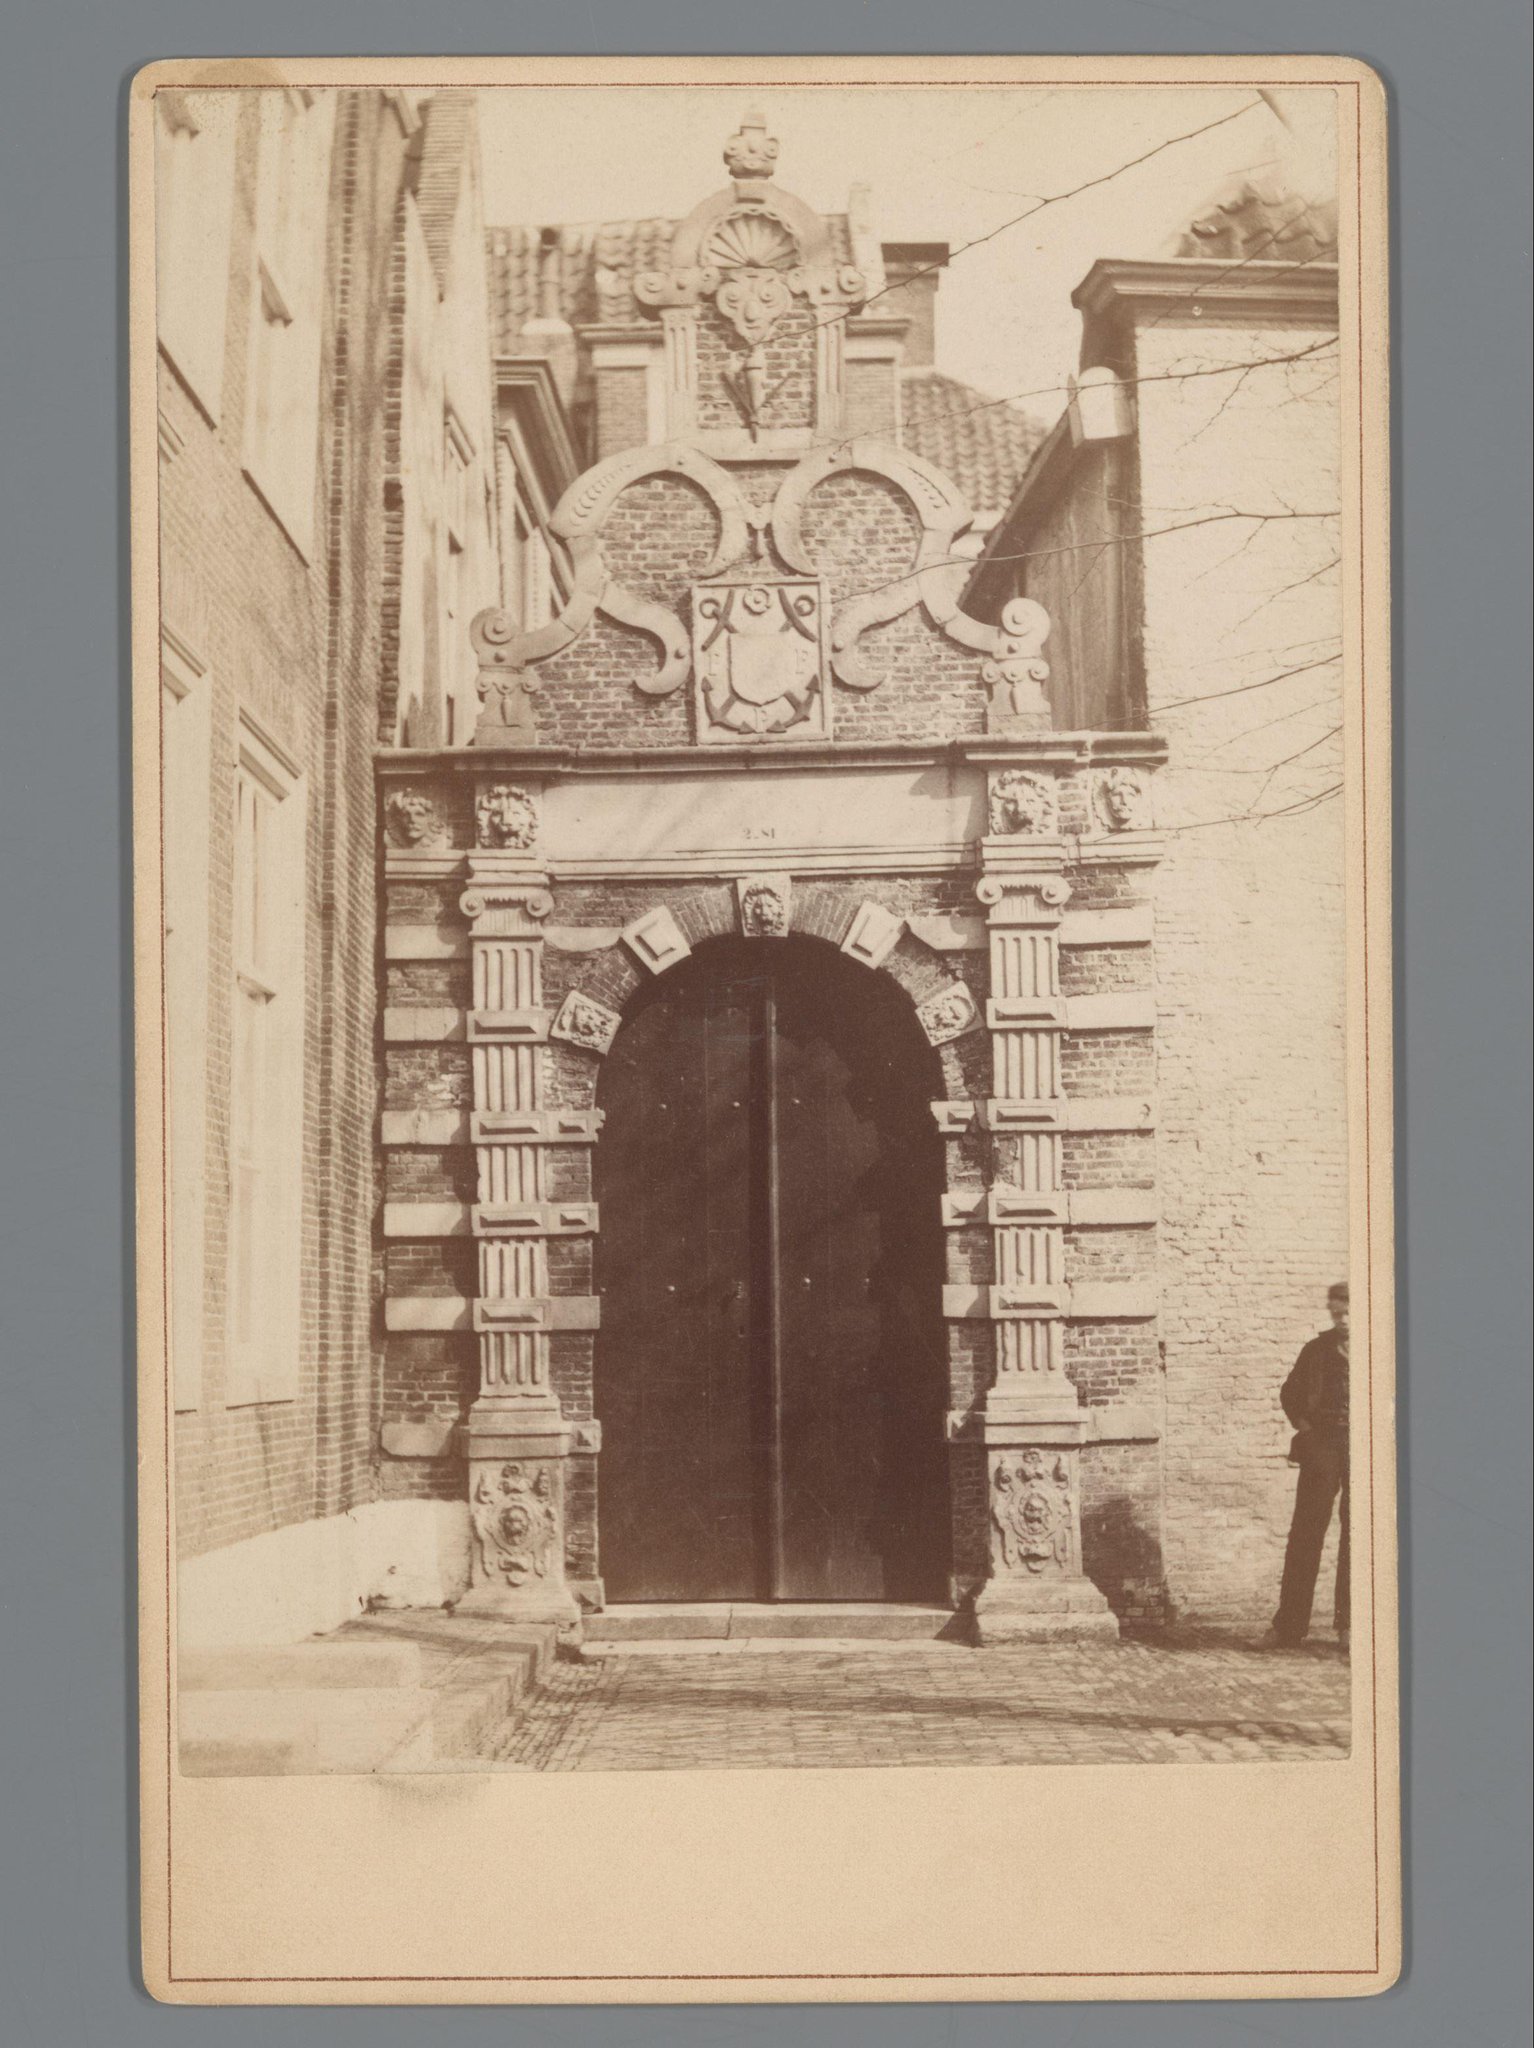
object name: photograph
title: Admiraliteitspoortje op Kerkplein 23 te Hoorn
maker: Anonymous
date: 1870-1900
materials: cardboard, photographic support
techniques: albumen print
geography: hoorn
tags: gate, entrance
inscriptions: annotation: ‘N12 Poort Gasthuis/ Hoorn/ VI/3 h’